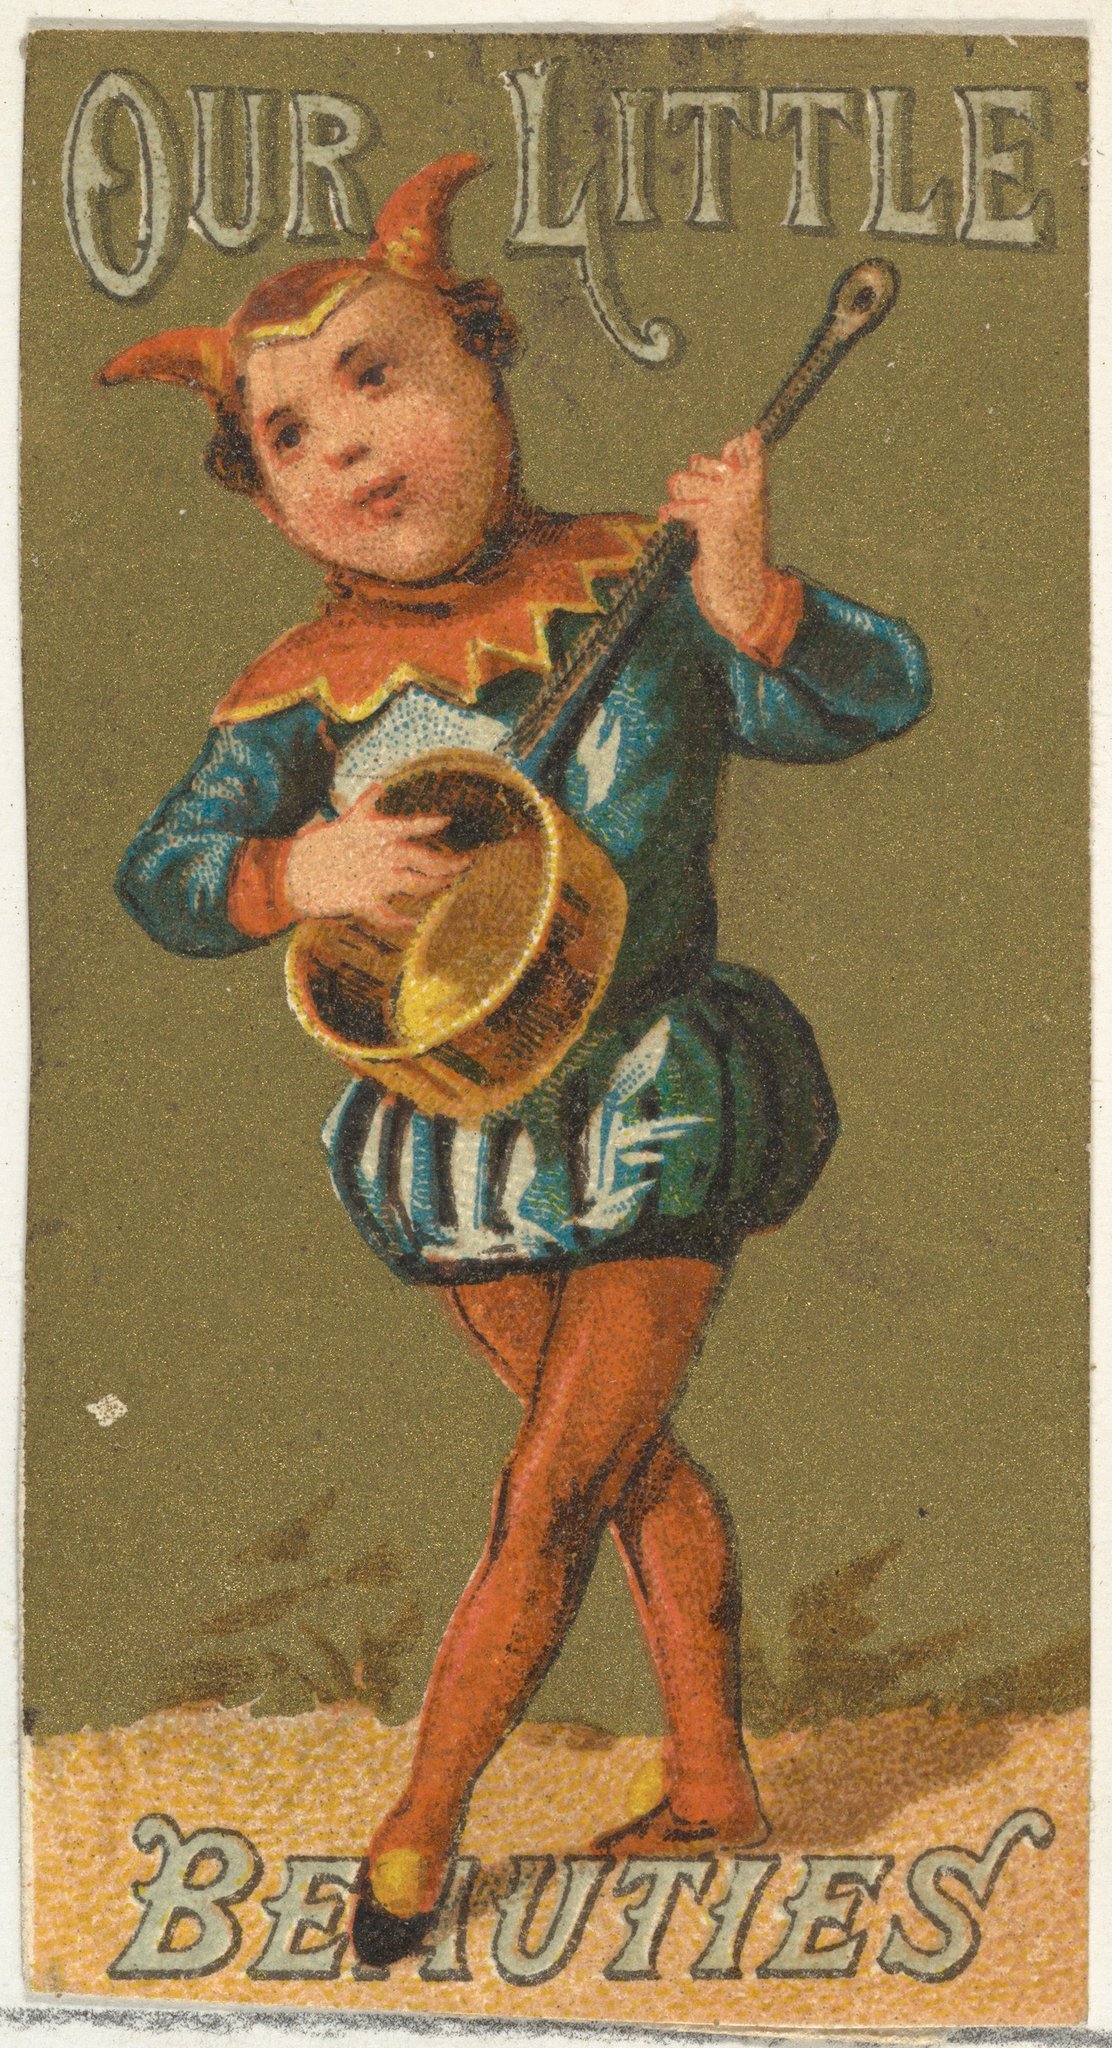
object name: print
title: From the Girls and Children series (N58) promoting Our Little Beauties Cigarettes for Allen & Ginter brand tobacco products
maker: allen & ginter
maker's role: publisher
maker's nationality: american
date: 1887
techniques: color lithograph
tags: musical instruments,girls